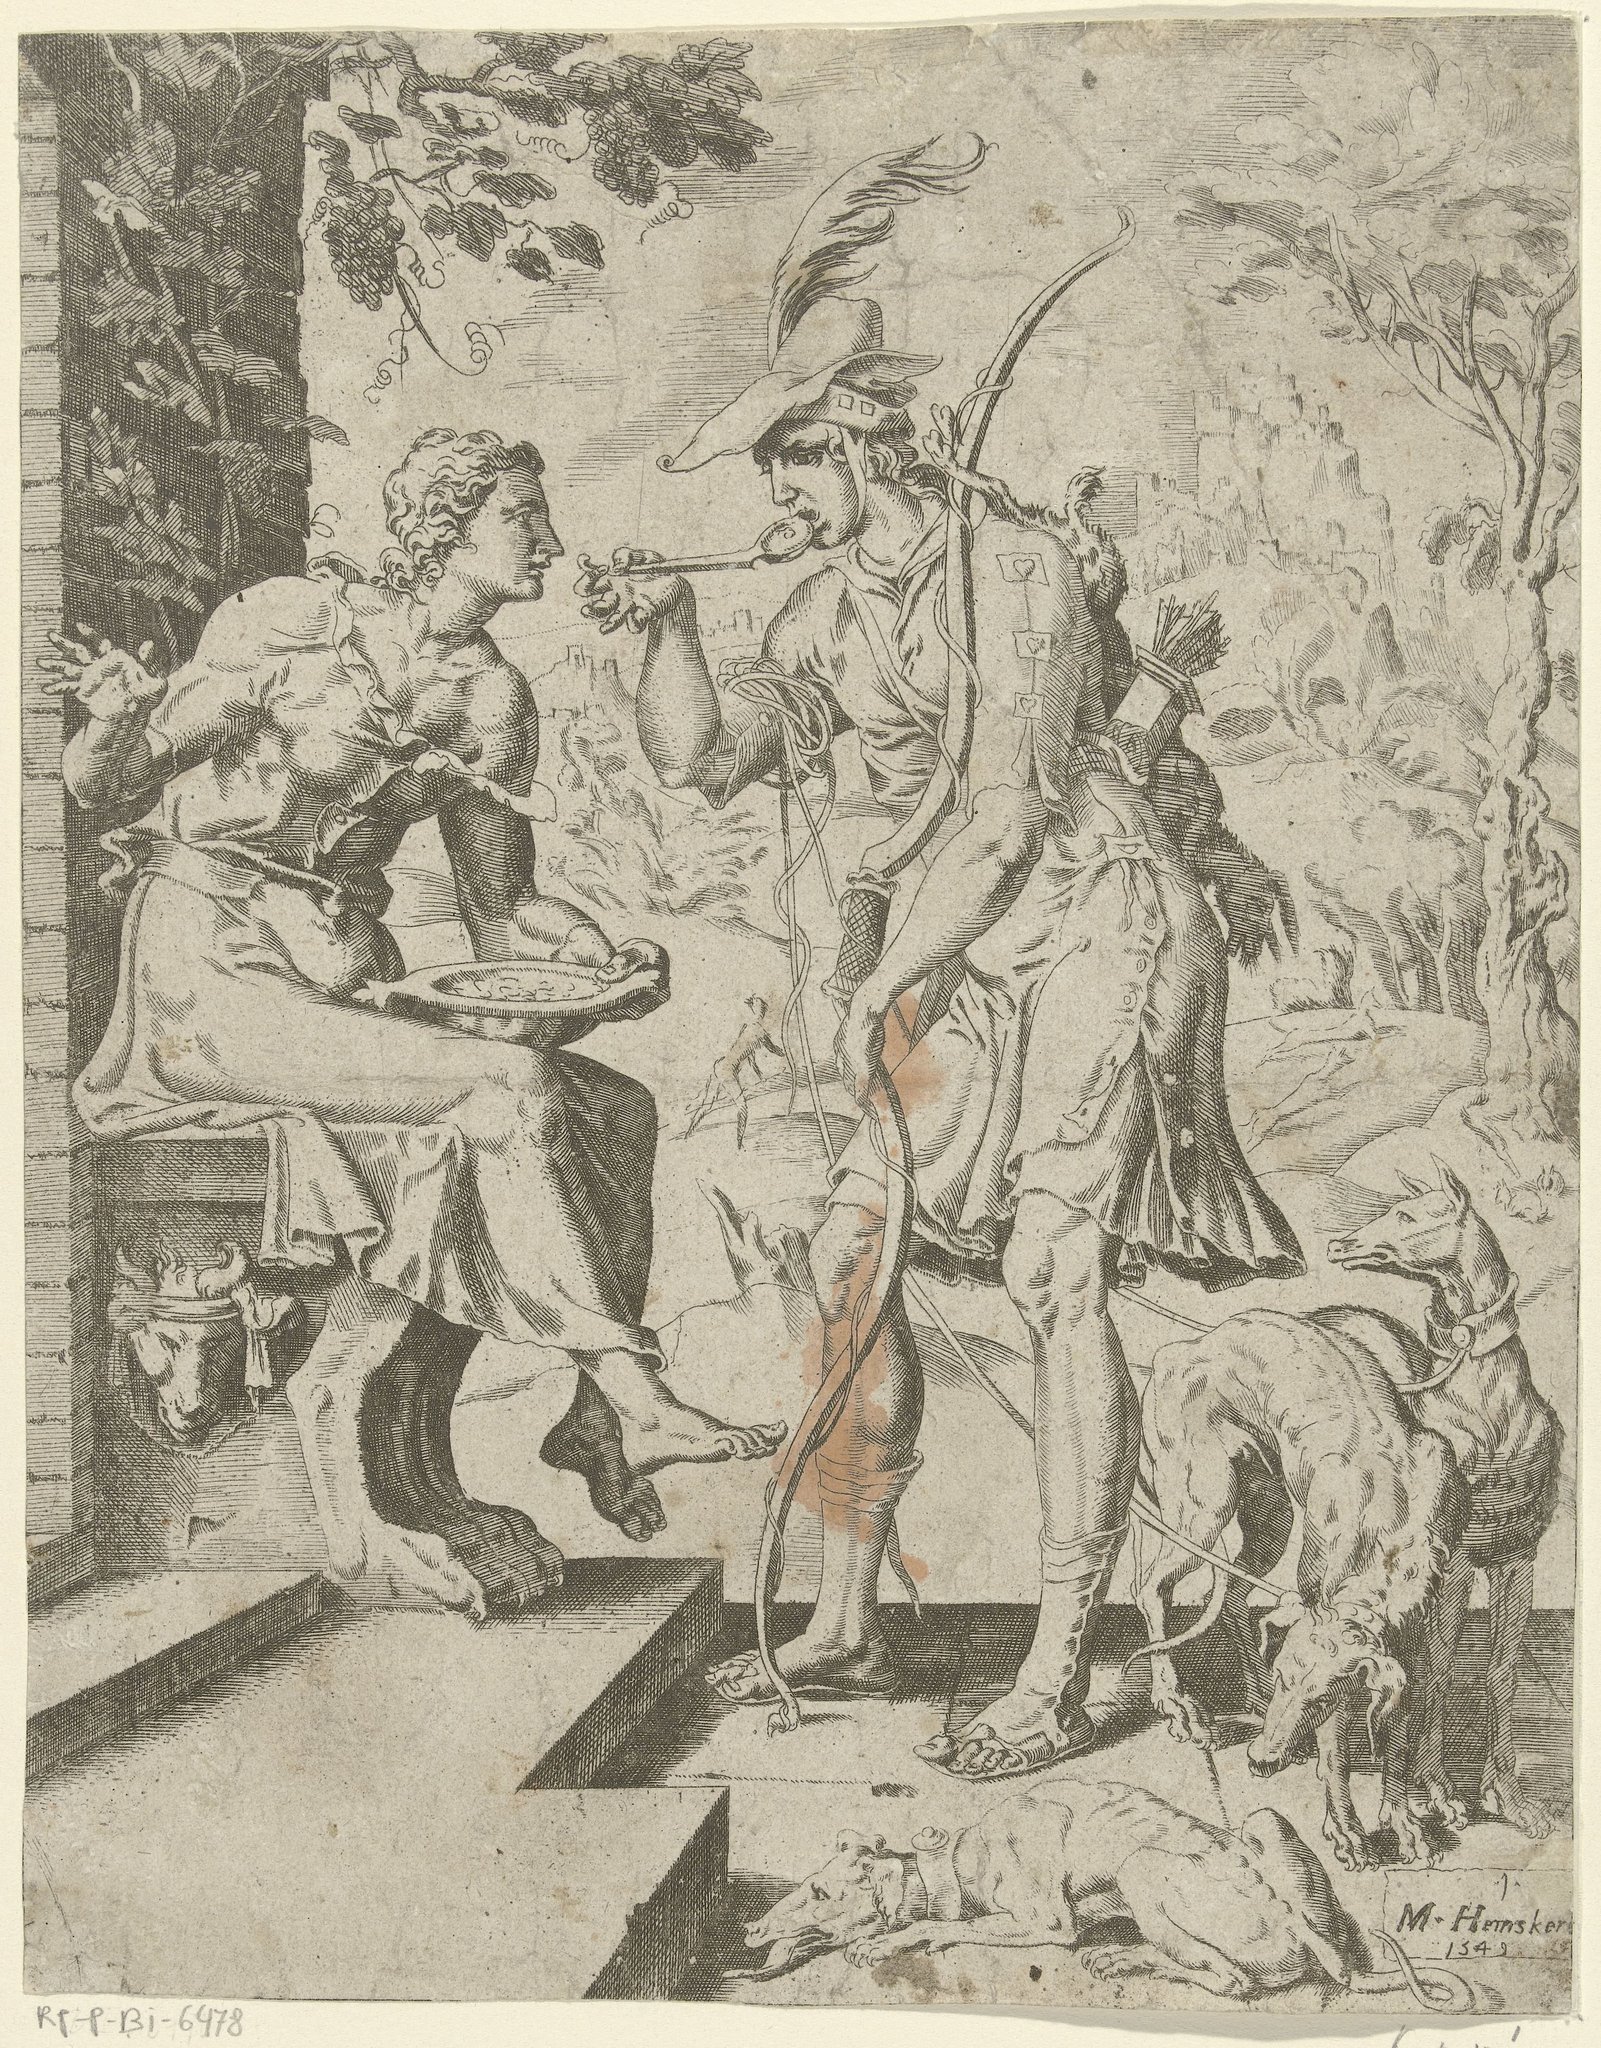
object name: print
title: Geschiedenis van Jakob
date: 1549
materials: paper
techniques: etching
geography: haarlem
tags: esau, returning hungry from the hunt, sells his first birthright to jacob for a pottage of lentils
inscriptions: date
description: Esau, gekleed als jager, heeft zijn eerstgeboorterecht verkocht aan Jakob voor een bord linzen. Hij doet zich te goed aan de linzen. Jakob zit tegenover hem. De prent maakt deel uit van een serie over de geschiedenis van Jakob.